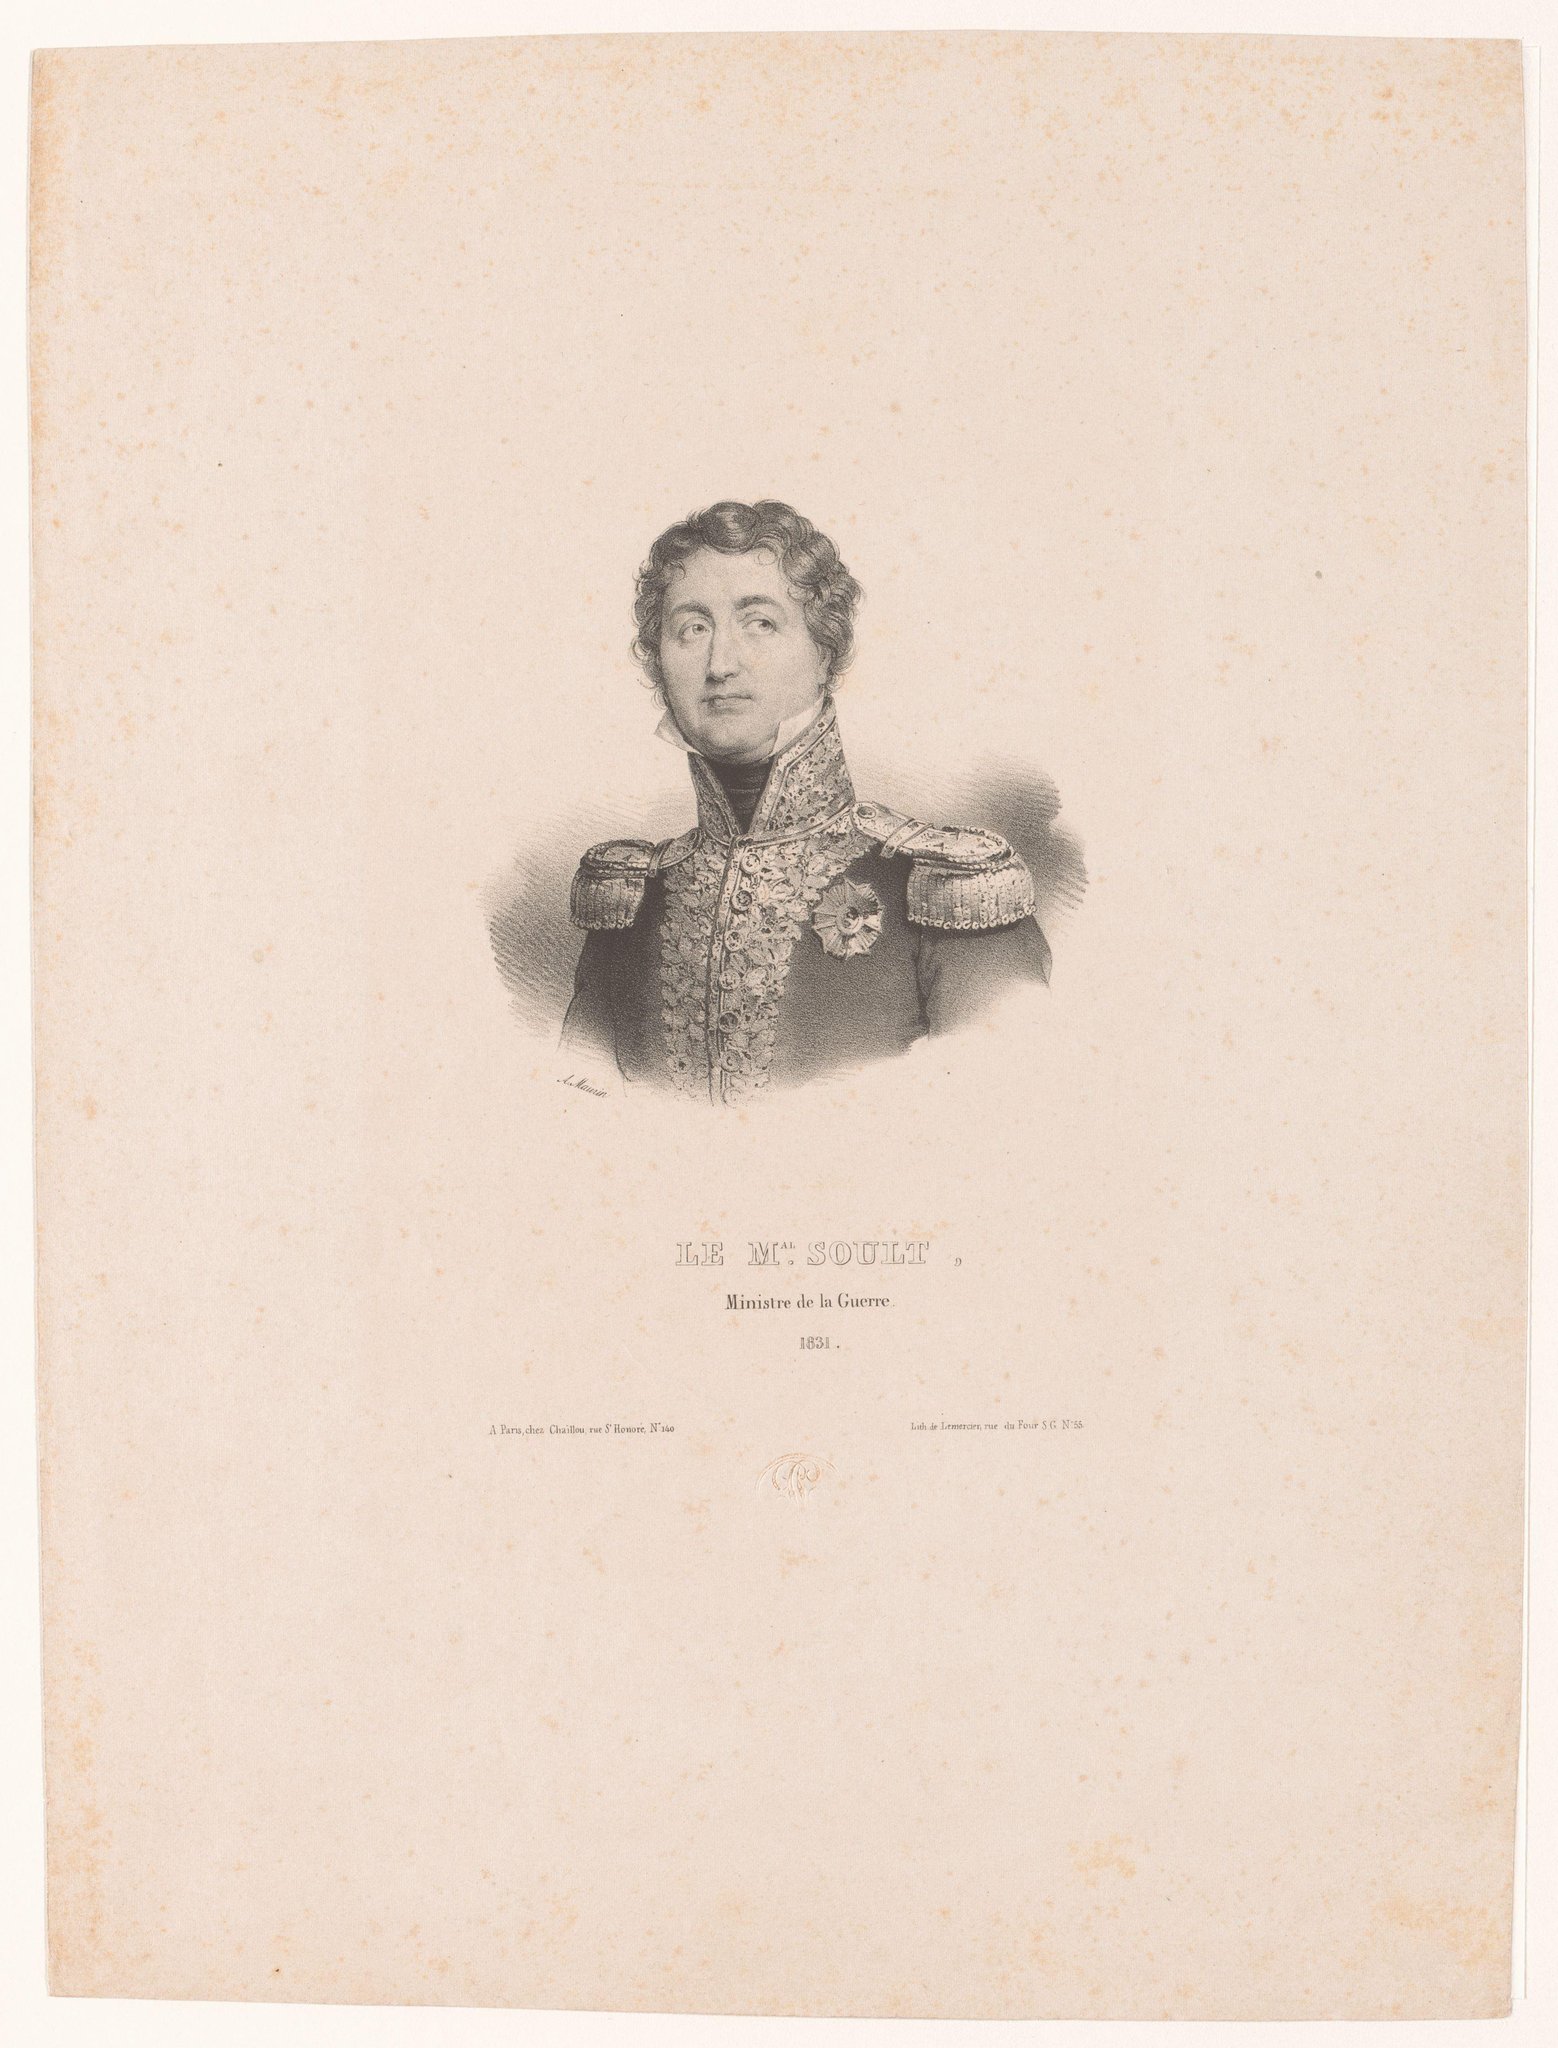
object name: print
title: Le Mal. Soult, ministre de la guerre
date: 1831-1838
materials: paper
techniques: lithograph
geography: paris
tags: commander-in-chief, general, marshal, historical persons, politician, e.g. party leader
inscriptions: collector's mark: Lugt 2228, check stamp: Lugt 619